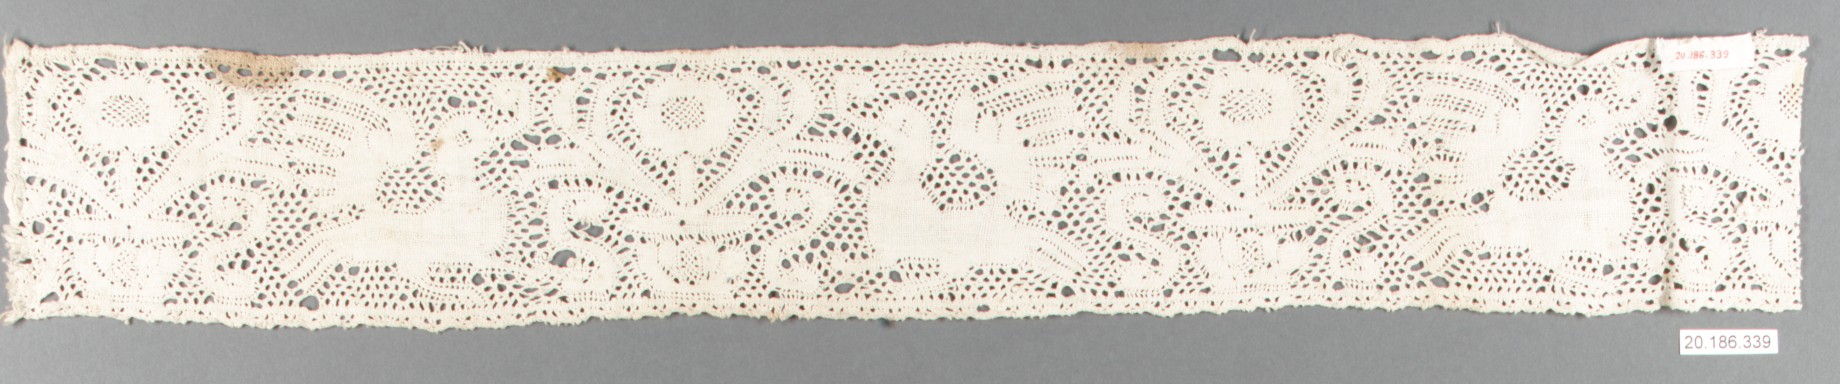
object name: edging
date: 1701-1800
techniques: lace